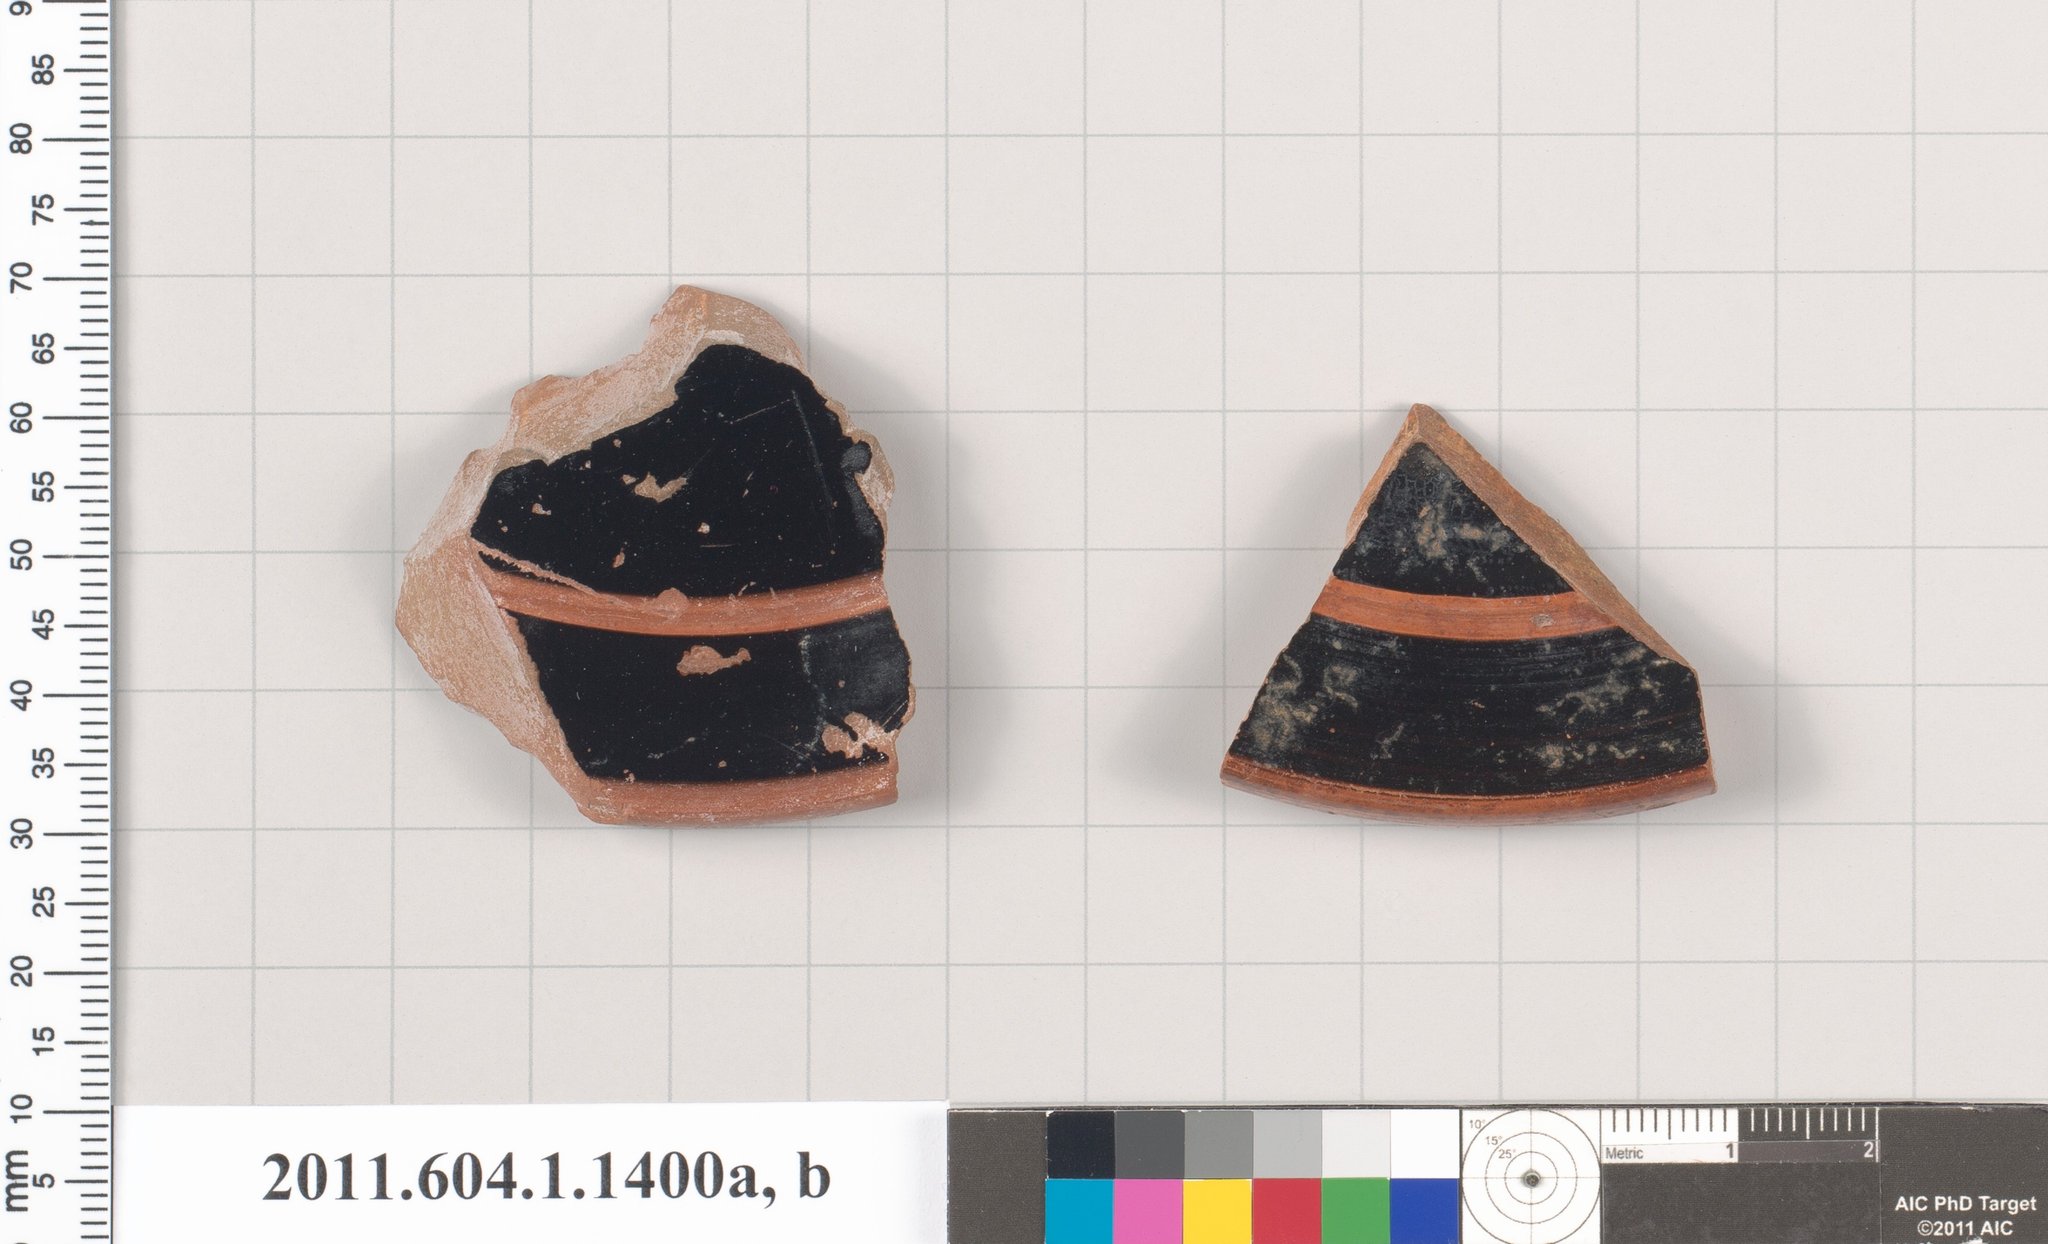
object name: kylix fragment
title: Terracotta fragments of kylikes (drinking cups)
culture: greek, attic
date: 500-401 BCE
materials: terracotta